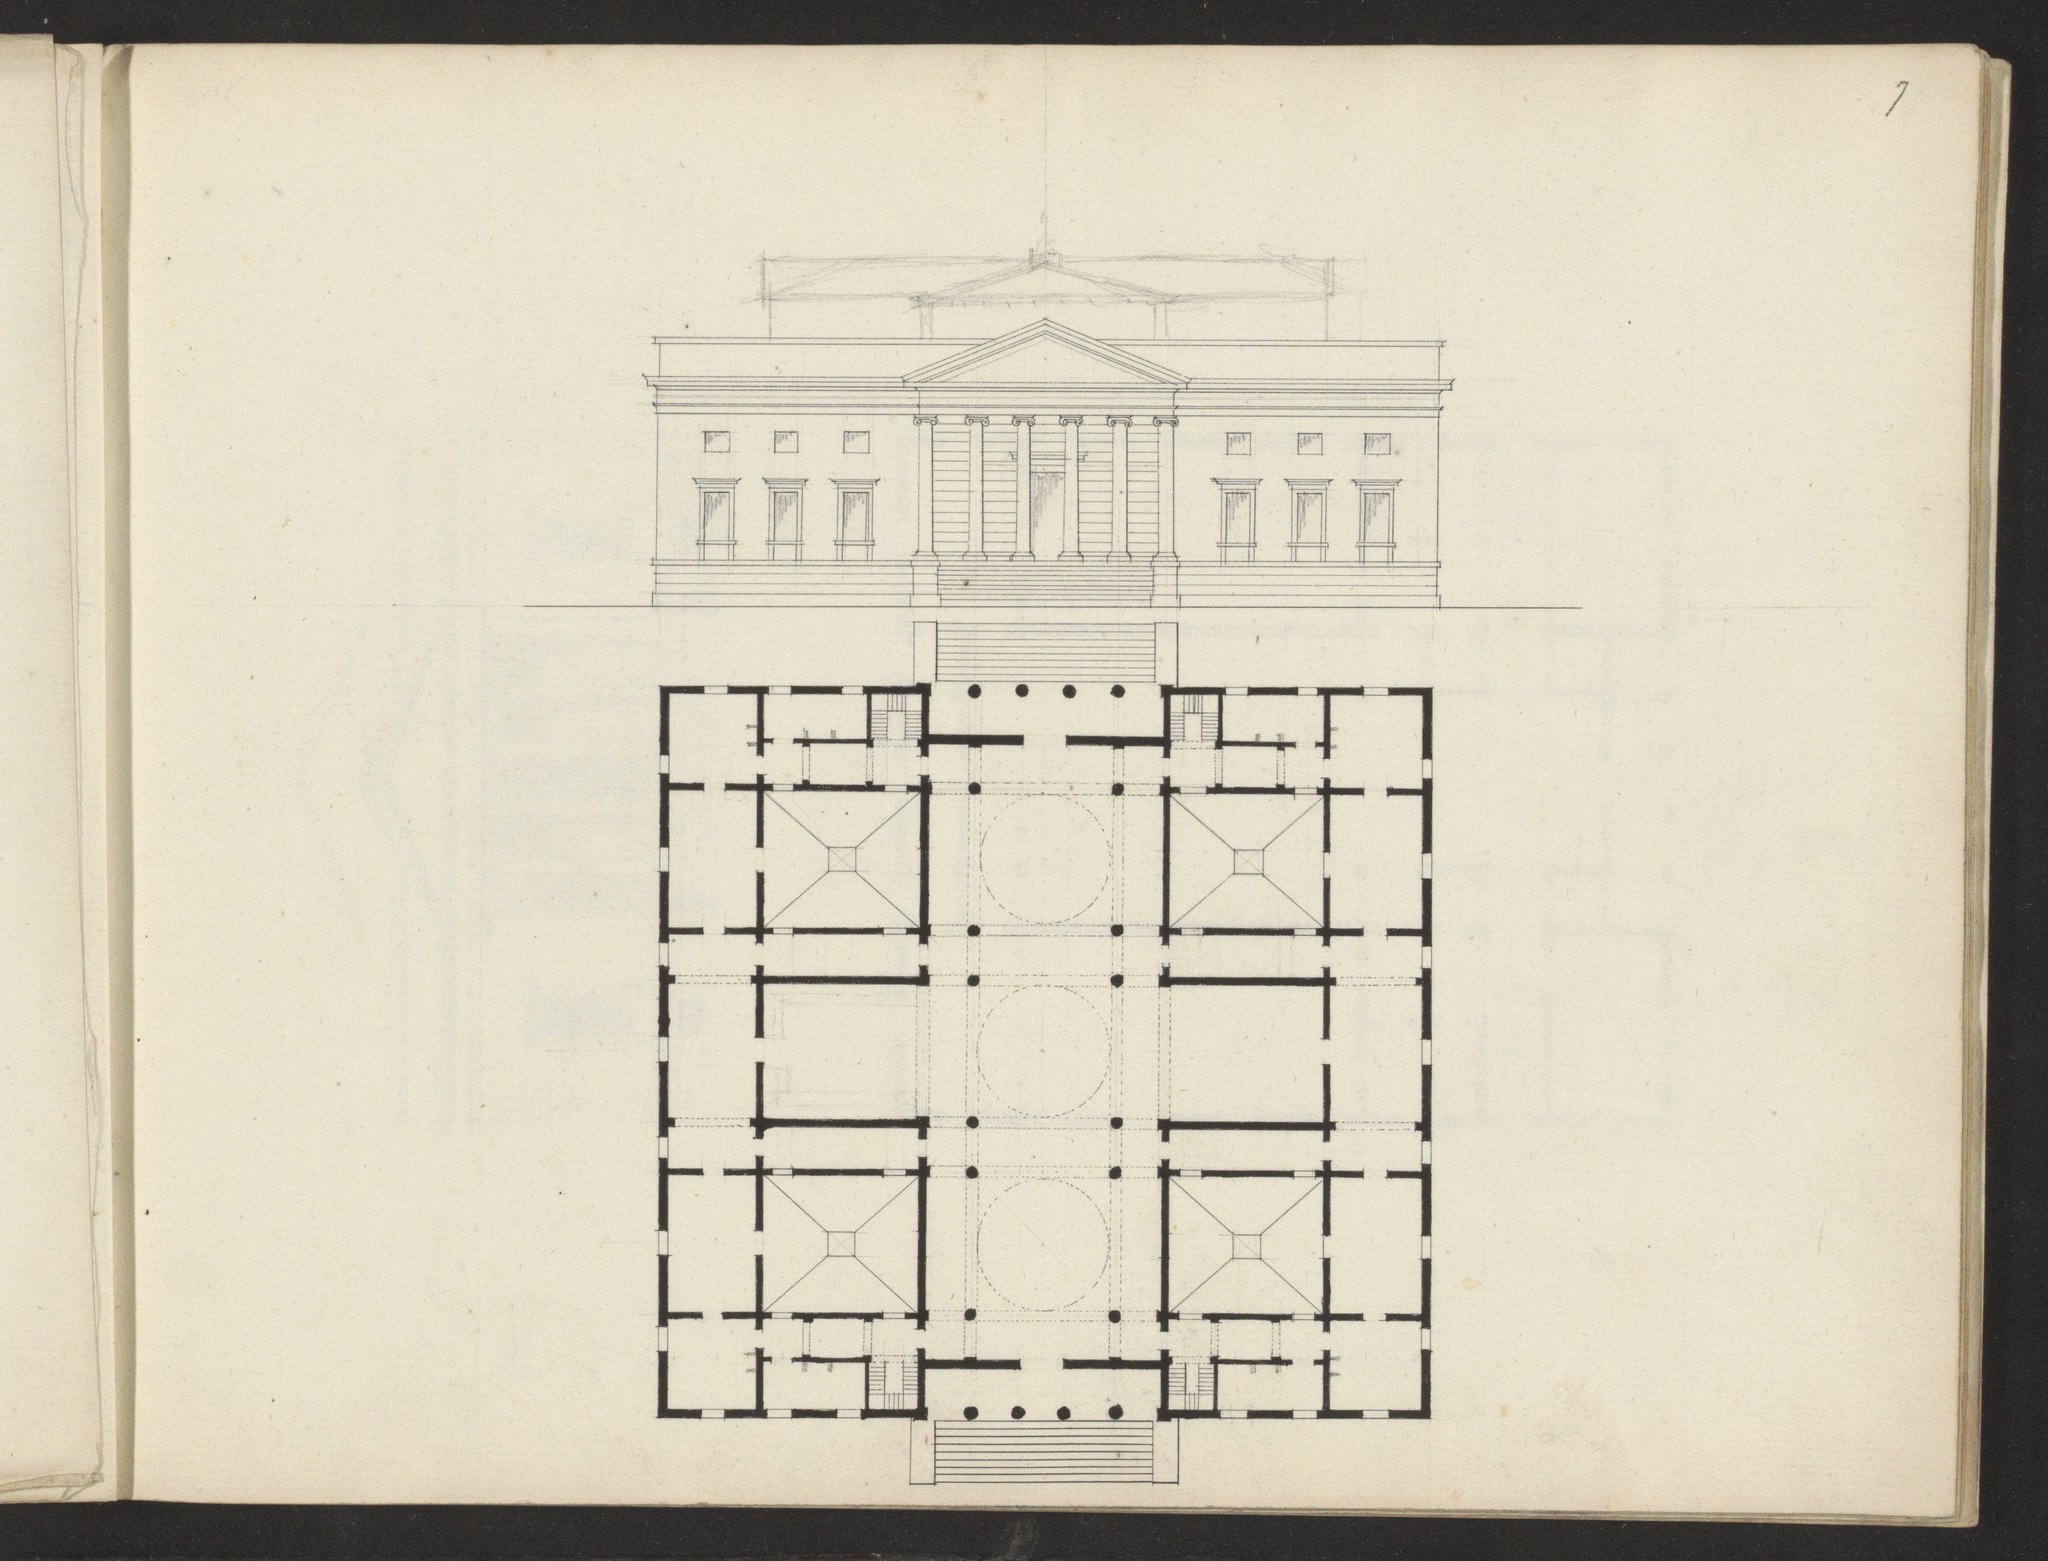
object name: sketchbook leaf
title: Plattegrond en opstand van de voorgevel van een gebouw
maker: willem springer jr.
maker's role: draughtsman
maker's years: 1815-1907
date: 1825-1907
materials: ink, paper, pencil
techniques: pen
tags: façade (of house or building), plan ~ architecture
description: Pagina 7 uit een schetsboek met 28 pagina's.